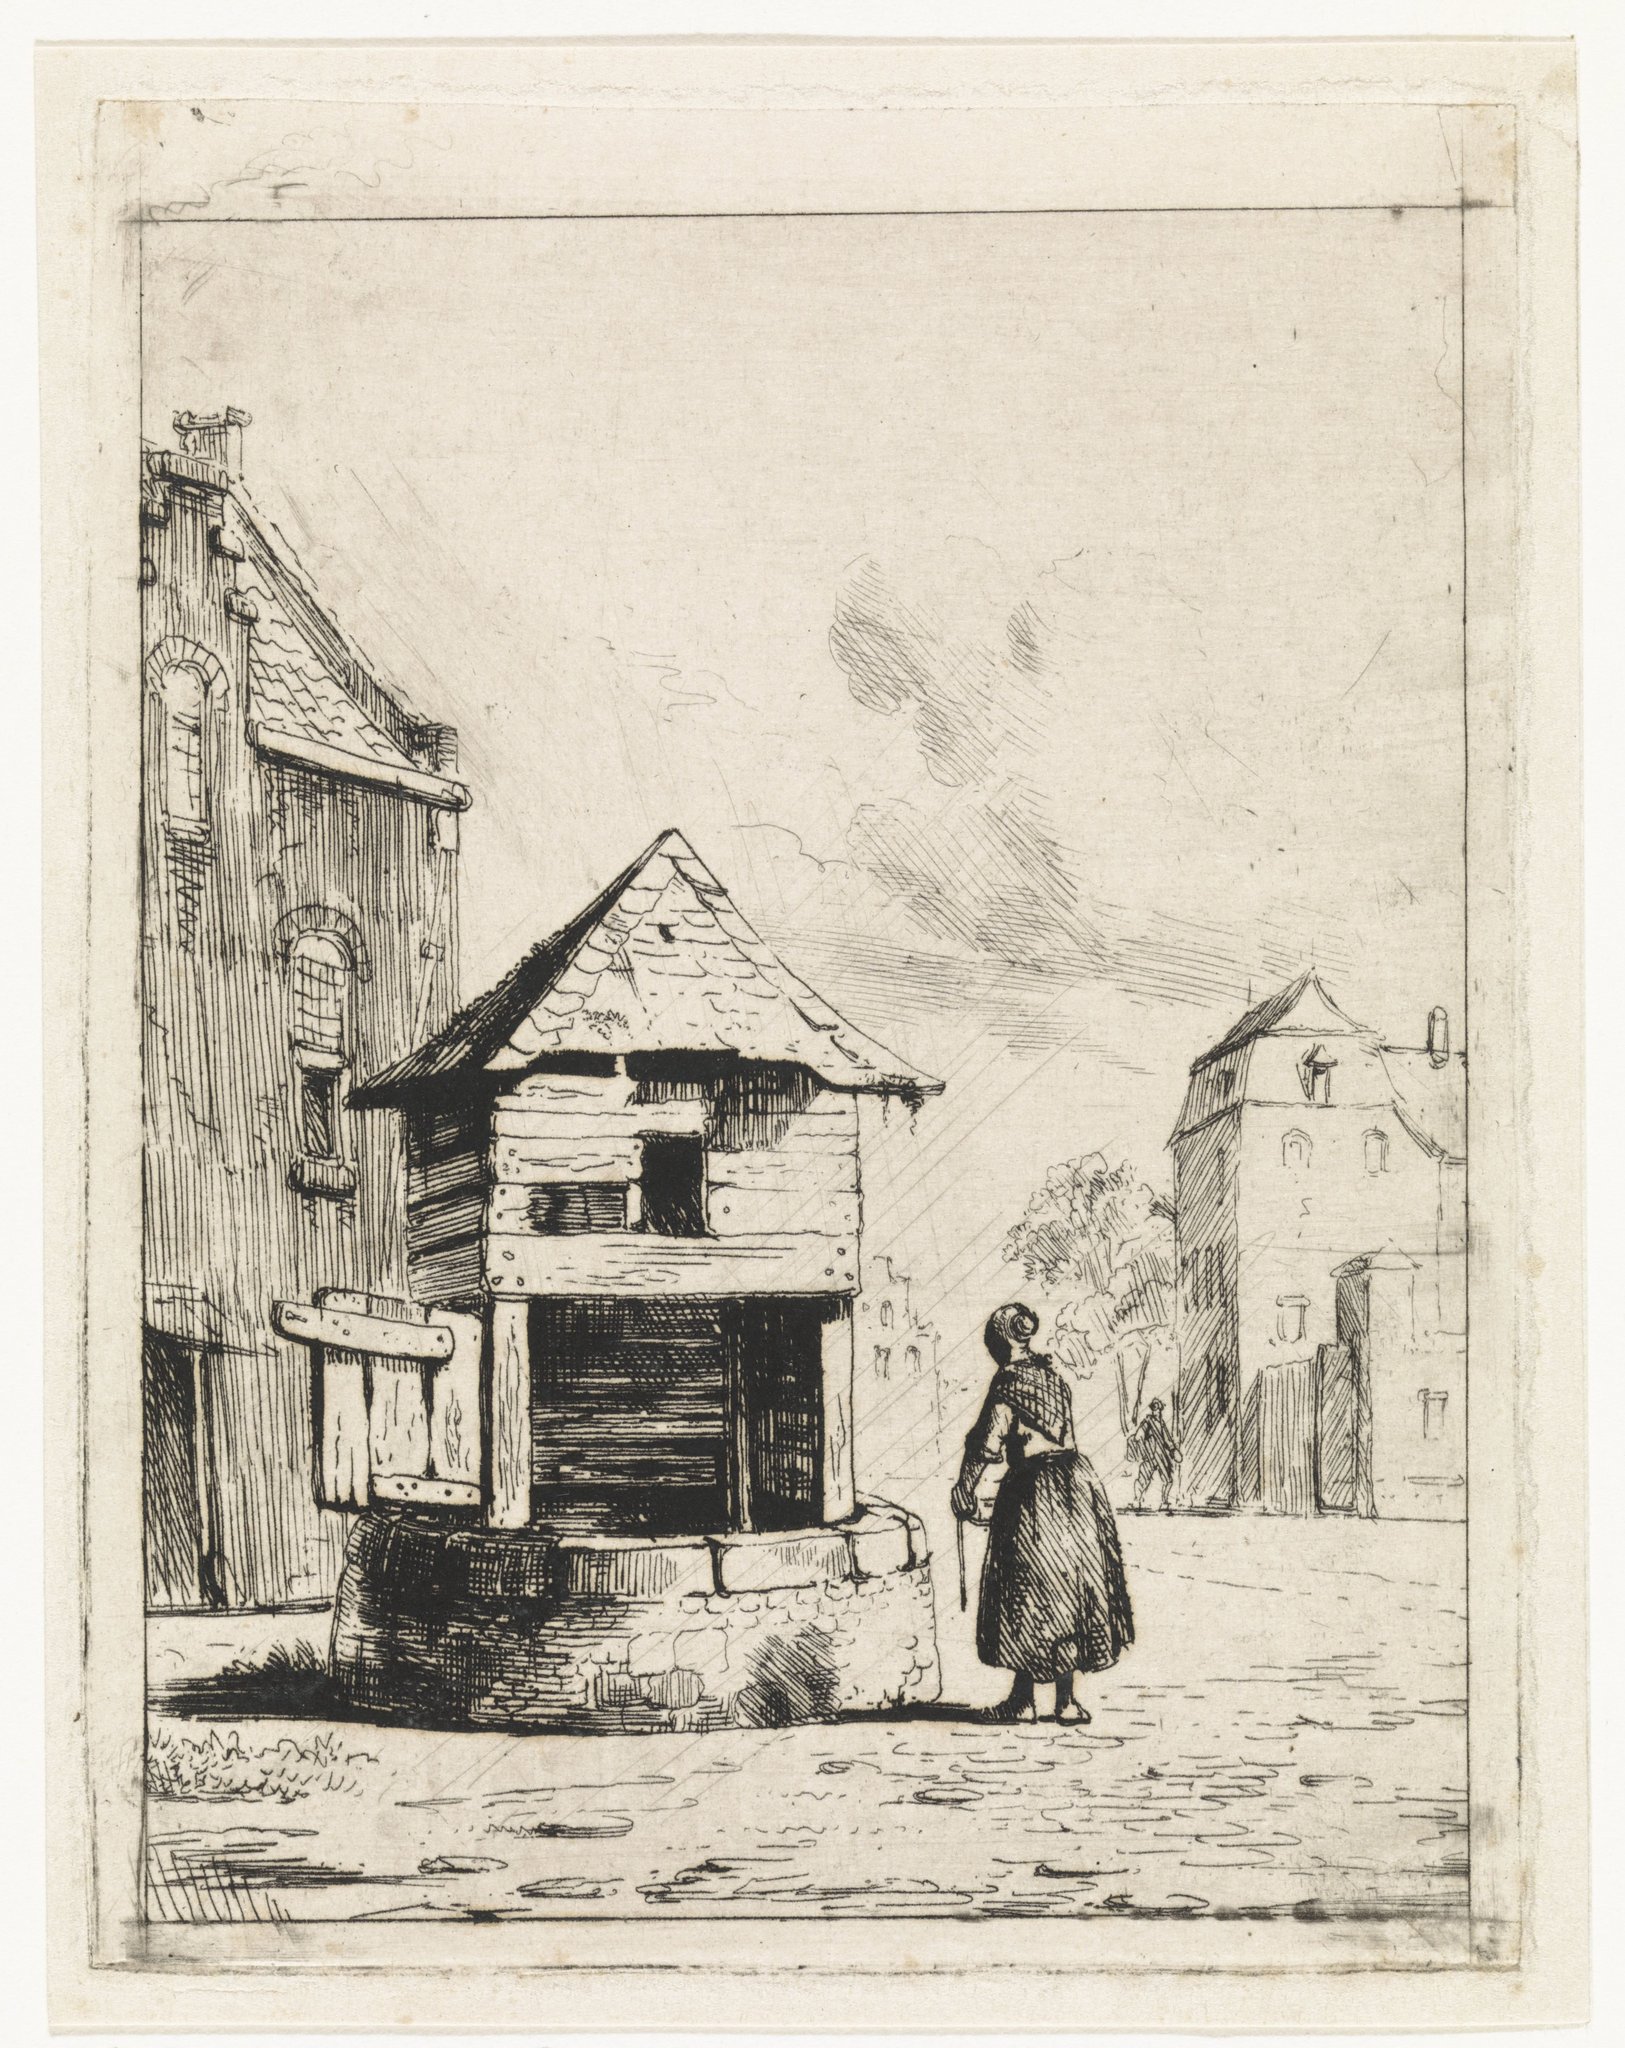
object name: print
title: Meisje bij een waterput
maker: cornelis springer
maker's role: draughtsman, painter, print maker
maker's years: 1817-1891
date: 1843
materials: paper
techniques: etching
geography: amsterdam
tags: well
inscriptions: collector's mark: Lugt 2228